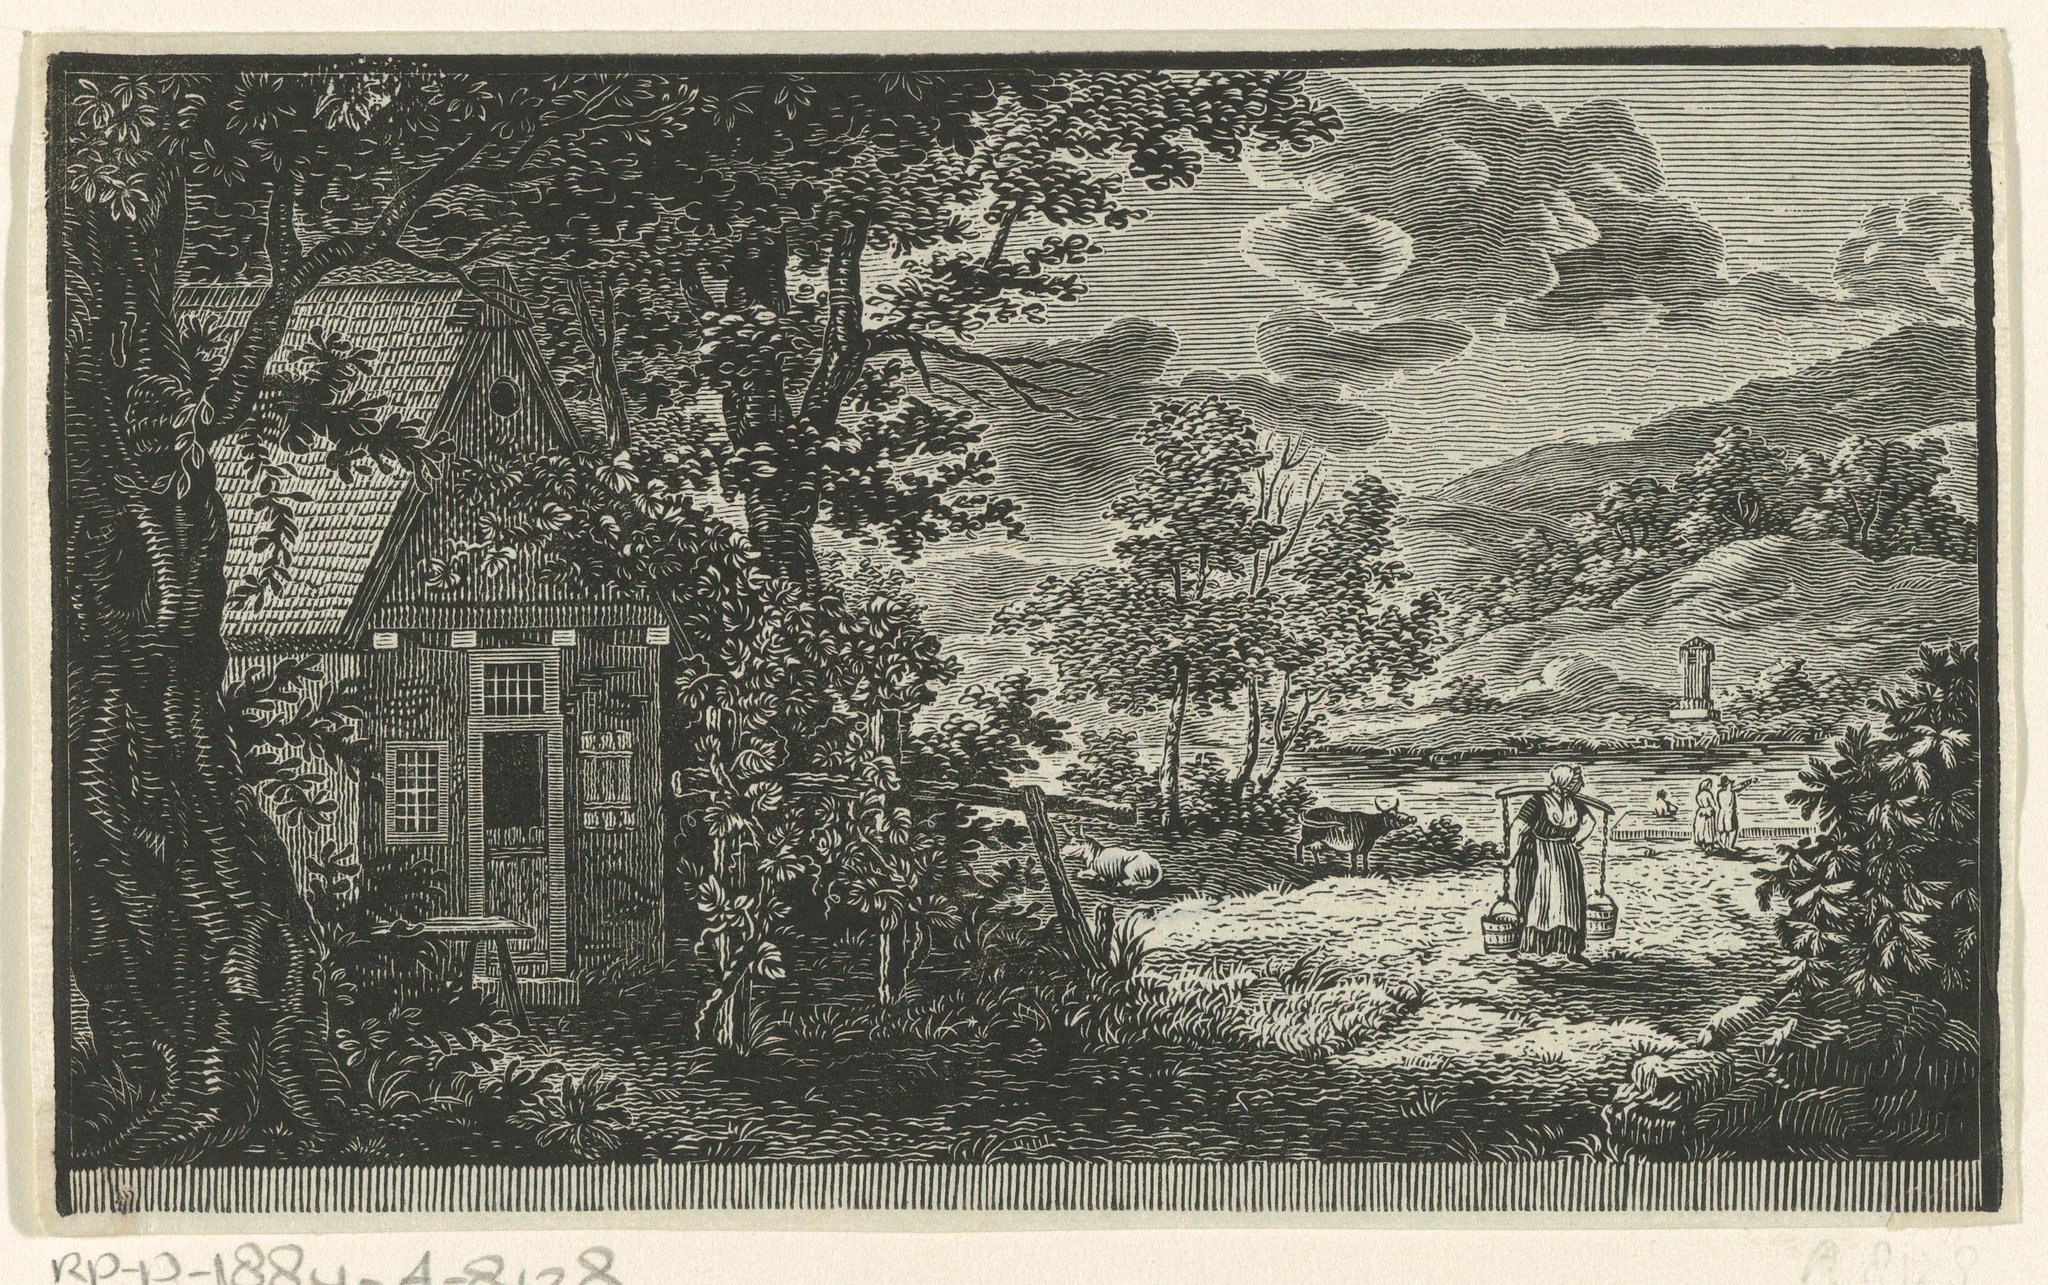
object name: print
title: Landschap met een boerenwoning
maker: alexander cranendoncq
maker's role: draughtsman, print maker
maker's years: 1799-1869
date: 1809-1869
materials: paper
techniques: engraving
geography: netherlands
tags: carrying something with yoke, farm or solitary house in landscape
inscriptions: collector's mark: Lugt 2228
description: Rechts loopt een vrouw met een juk over haar schouders.